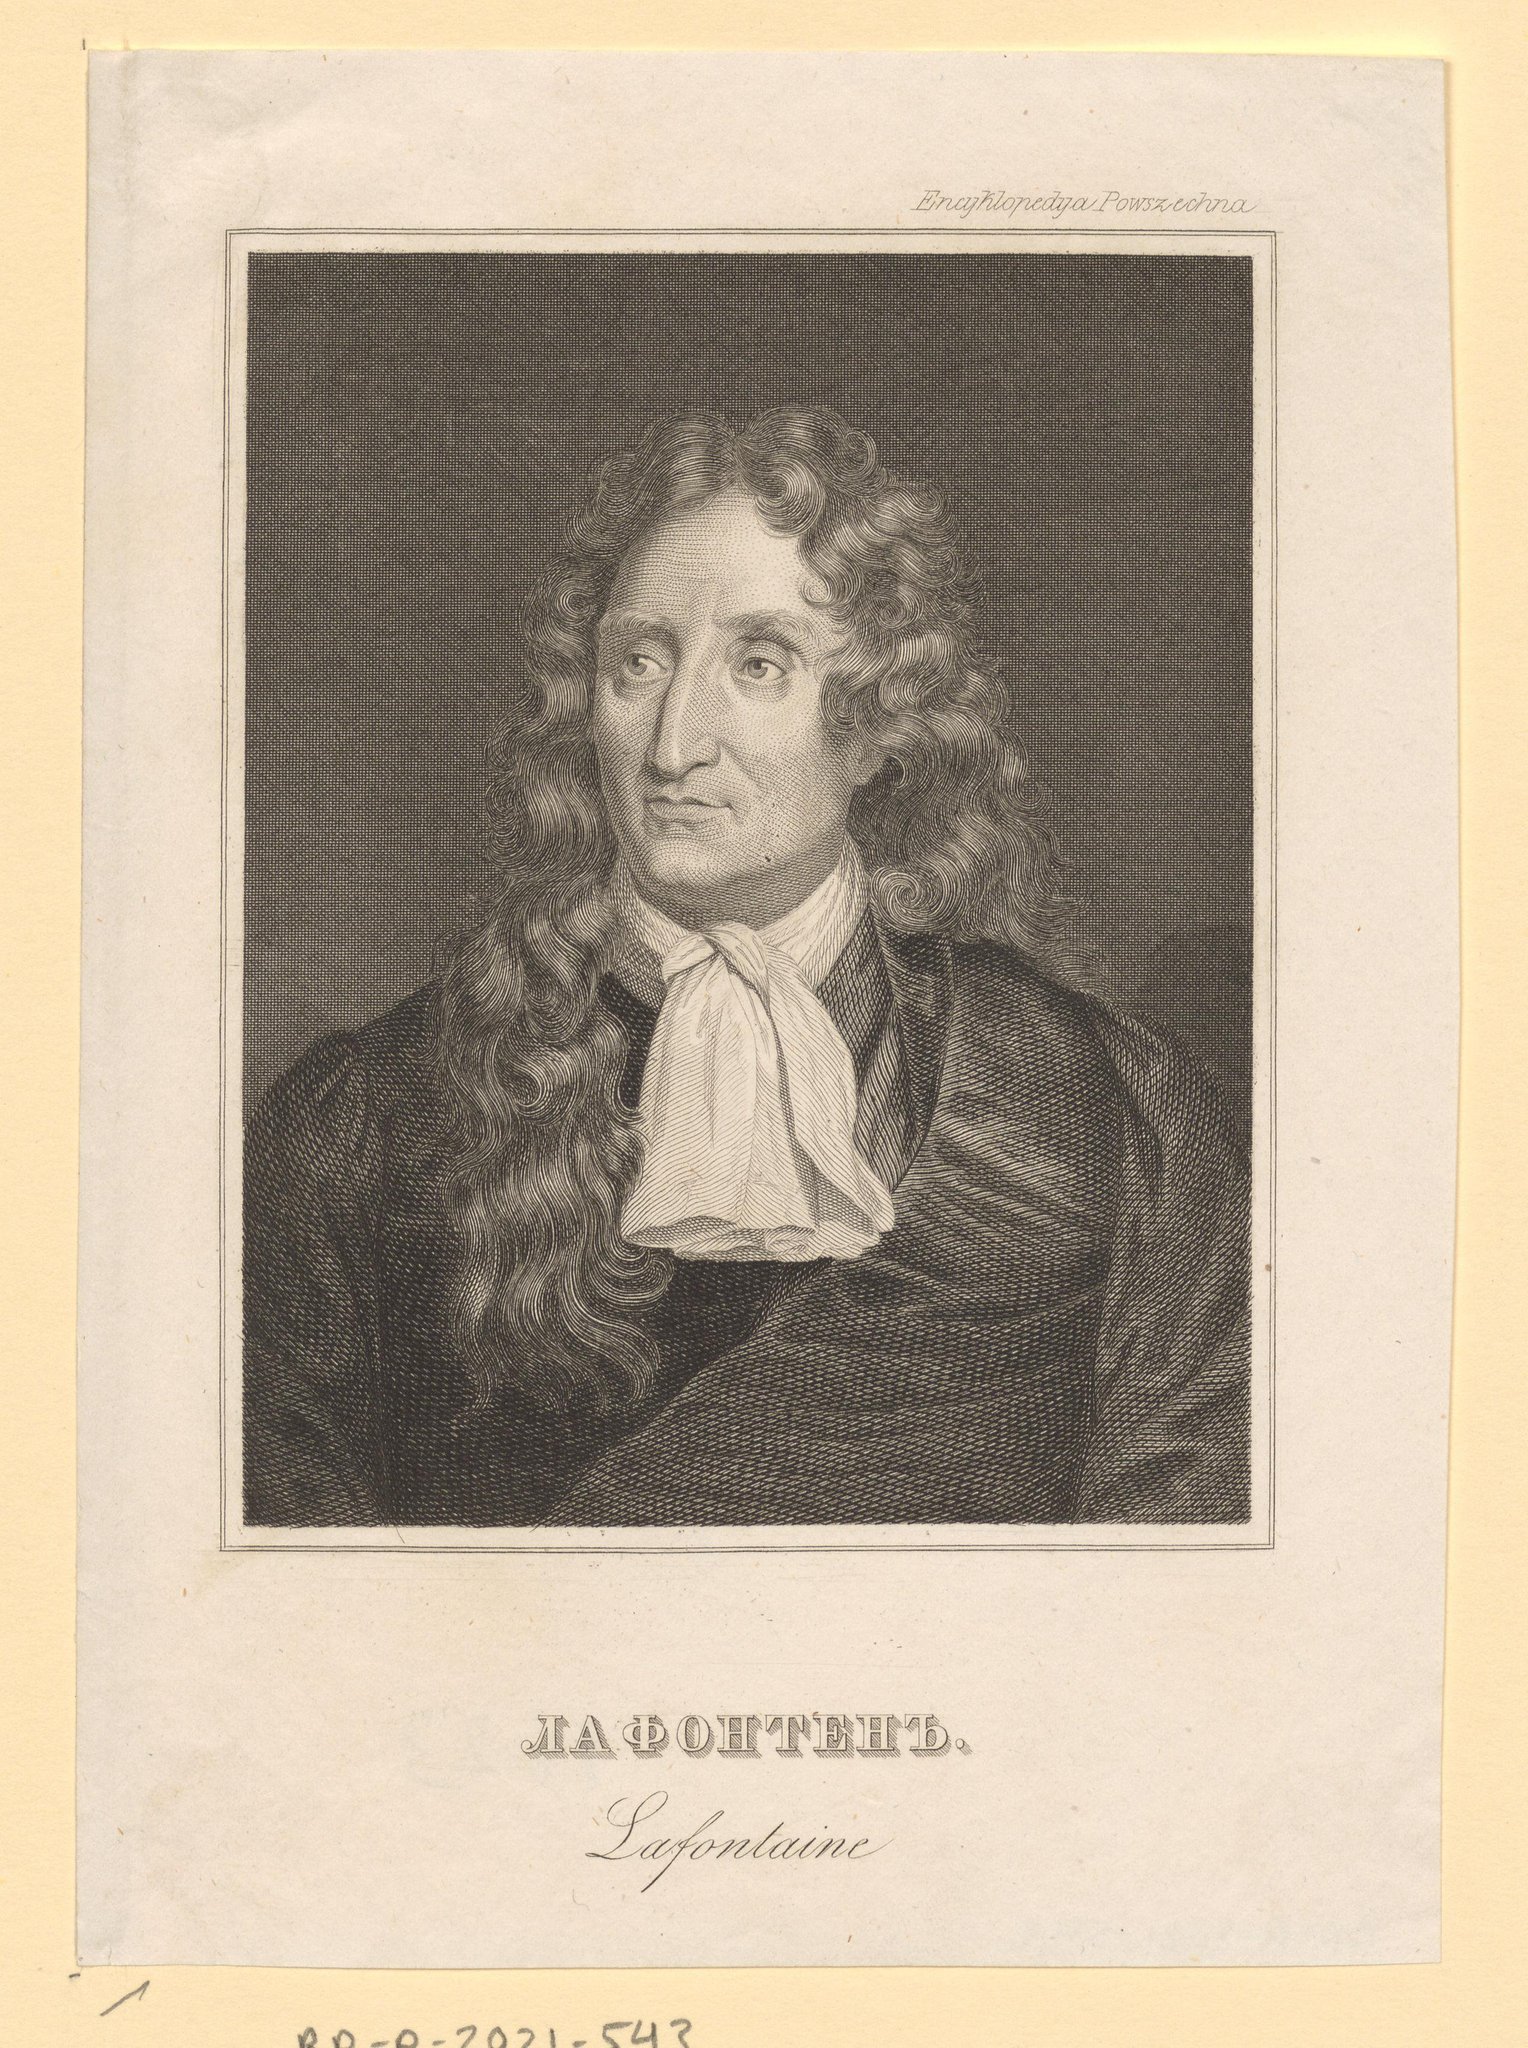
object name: print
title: Portret van Jean de La Fontaine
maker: Anonymous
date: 1836-1839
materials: paper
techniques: engraving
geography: poland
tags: paris, jean de la fontaine, historical persons, portrait of a writer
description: Prent waarschijnlijk uit: Encyklopedya powszechna. Warschau: August Emmanuel Gücksberg, 1836-1839.